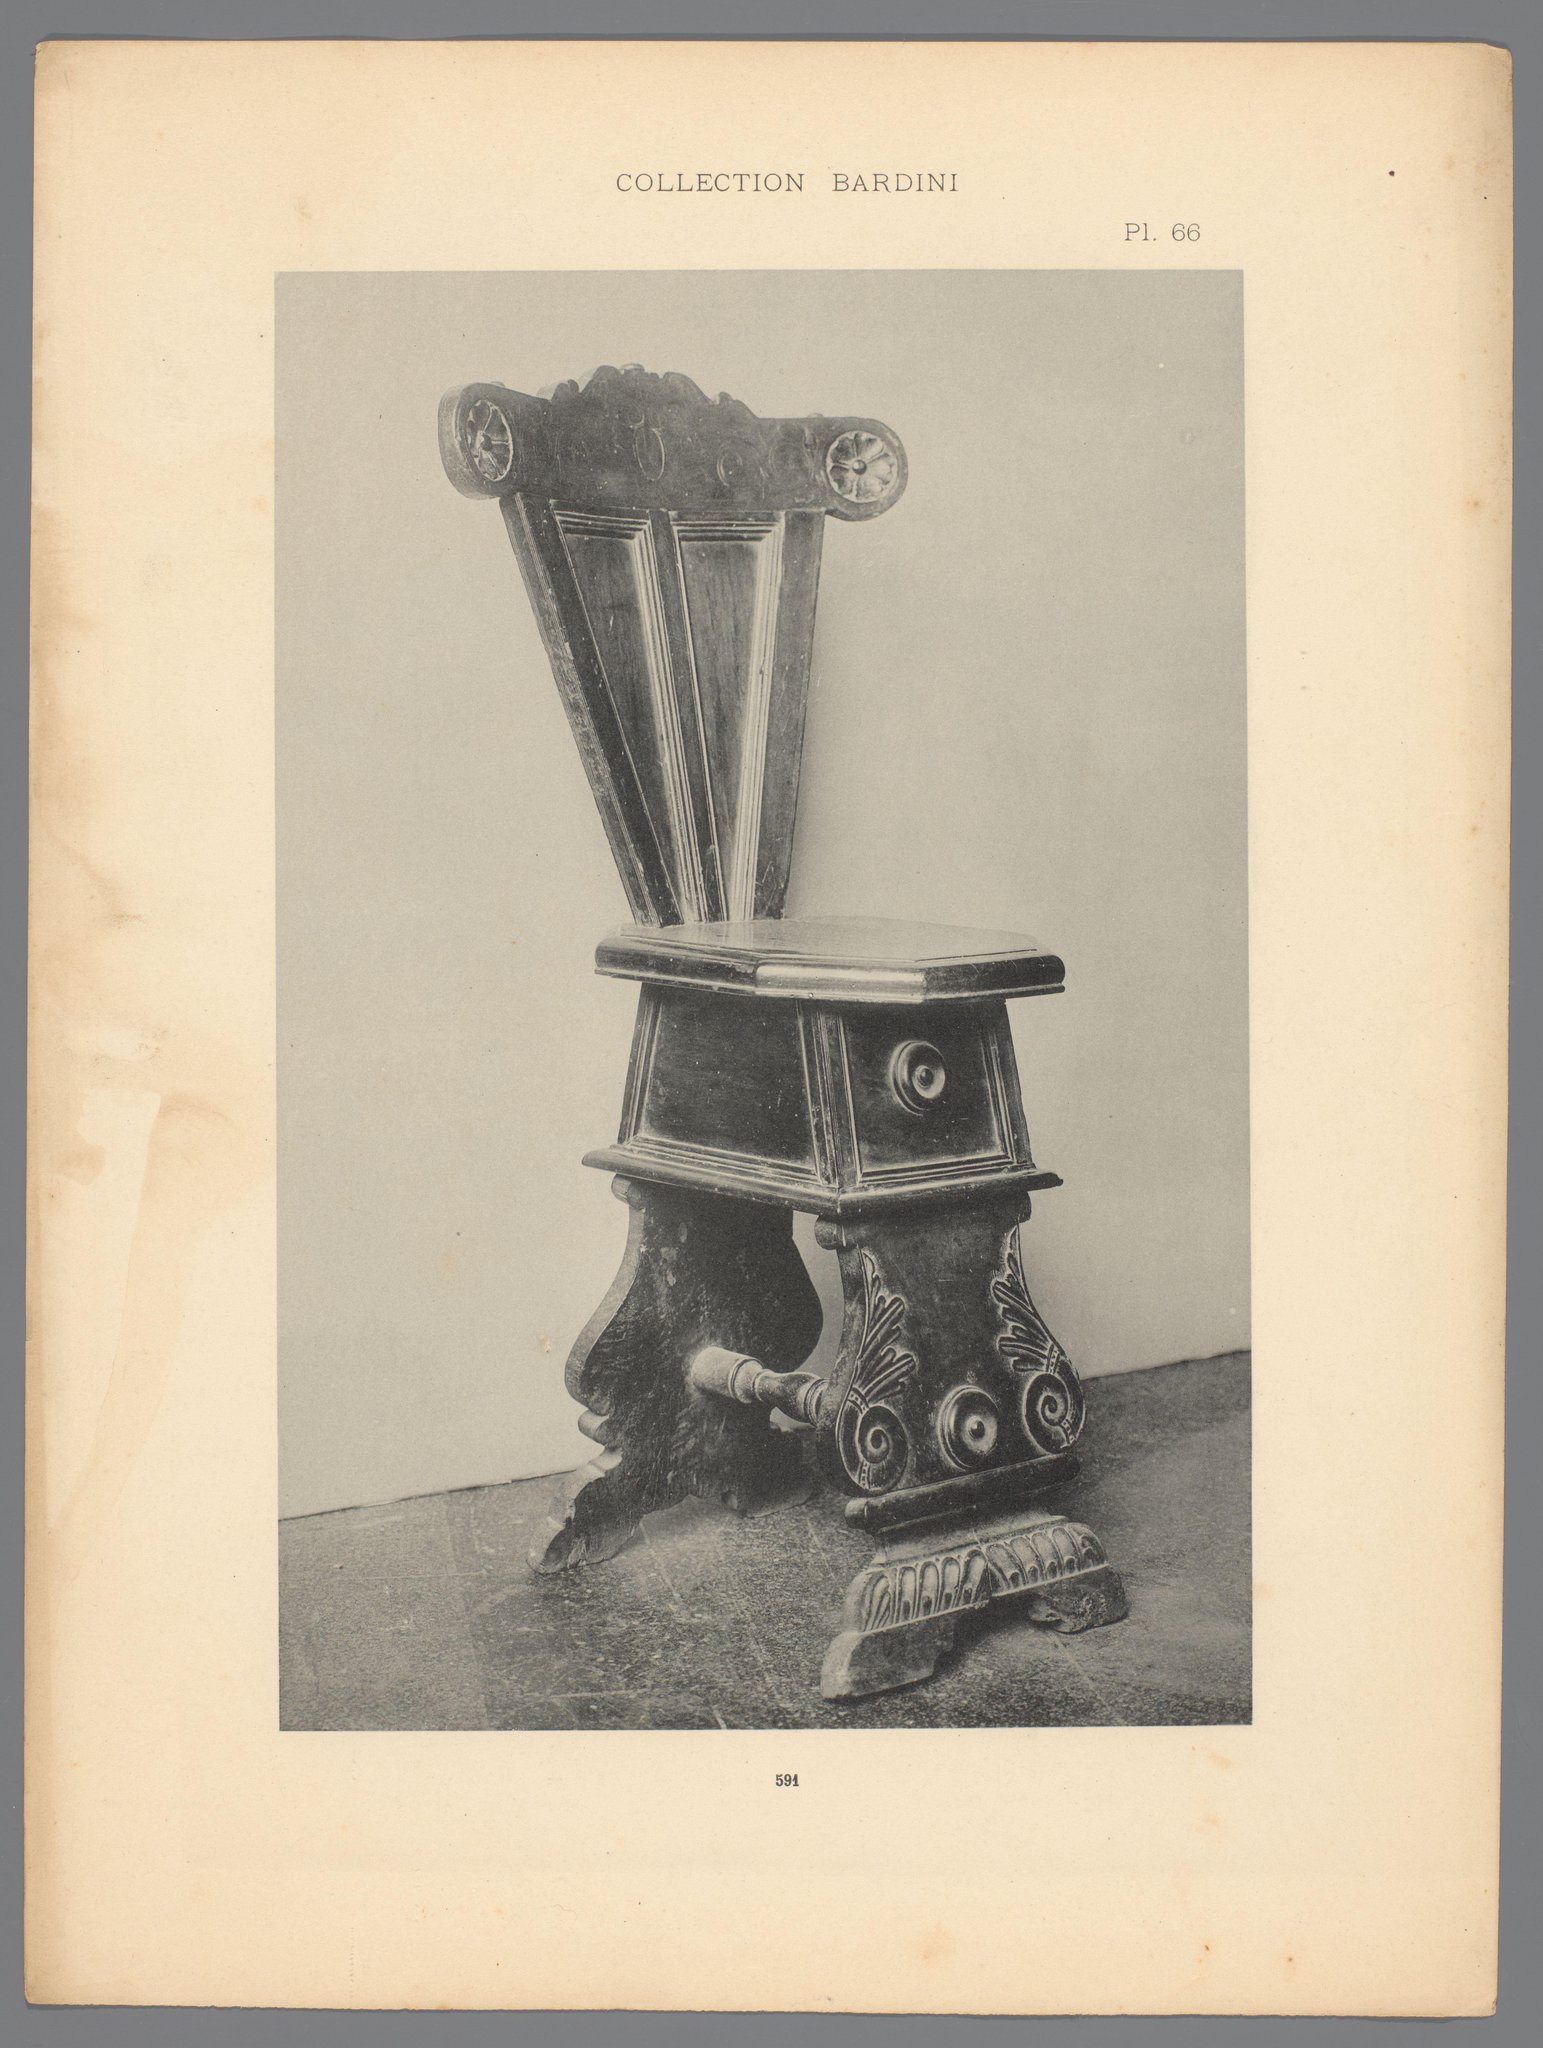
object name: photomechanical print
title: Collection Bardini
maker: Anonymous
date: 1875-1930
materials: paper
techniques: photograph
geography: florence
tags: decorative furniture, chair (+ wood and other phytogenic material)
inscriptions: number: ‘Pl. 66’, number: ‘15’